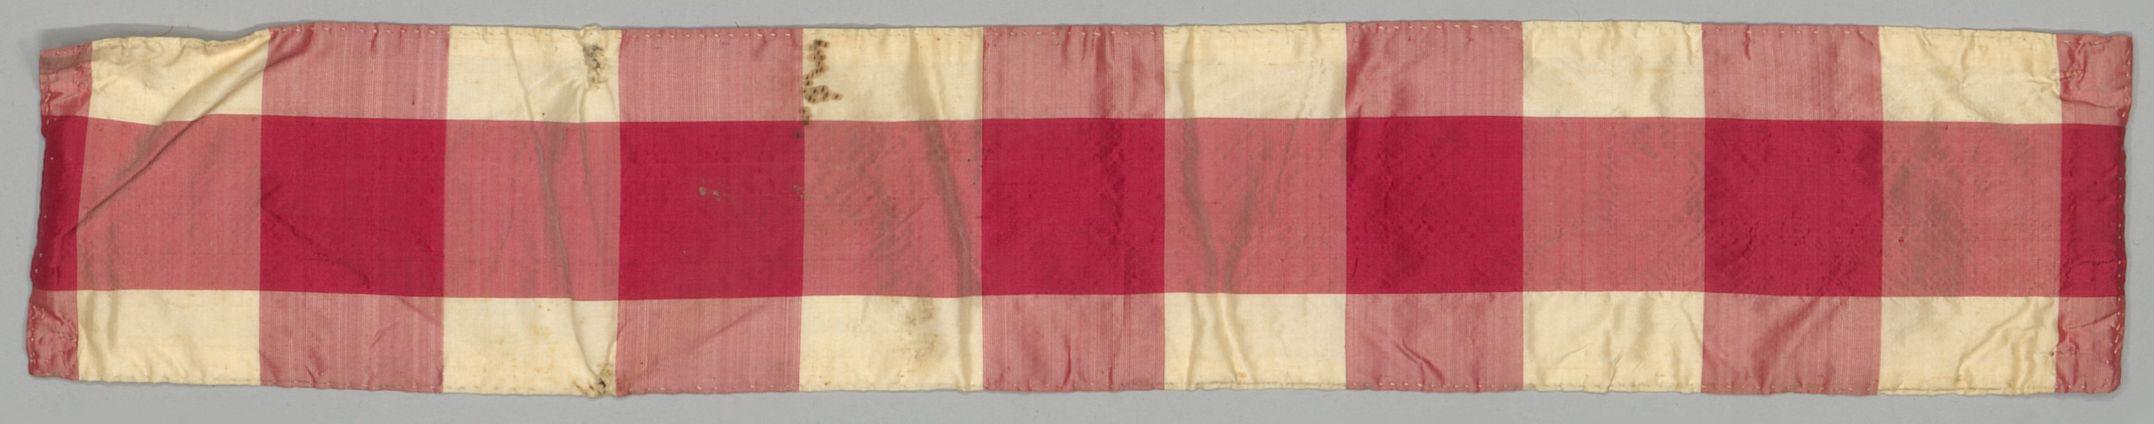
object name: tieback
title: Embrasse van rood-wit geblokte zijde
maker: Anonymous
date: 1776-1800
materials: linen, silk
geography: northern netherlands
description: Embrasse van rood-wit geblokte zijde, gevoerd met wit linnen en met twee stel metalen haken en ogen.